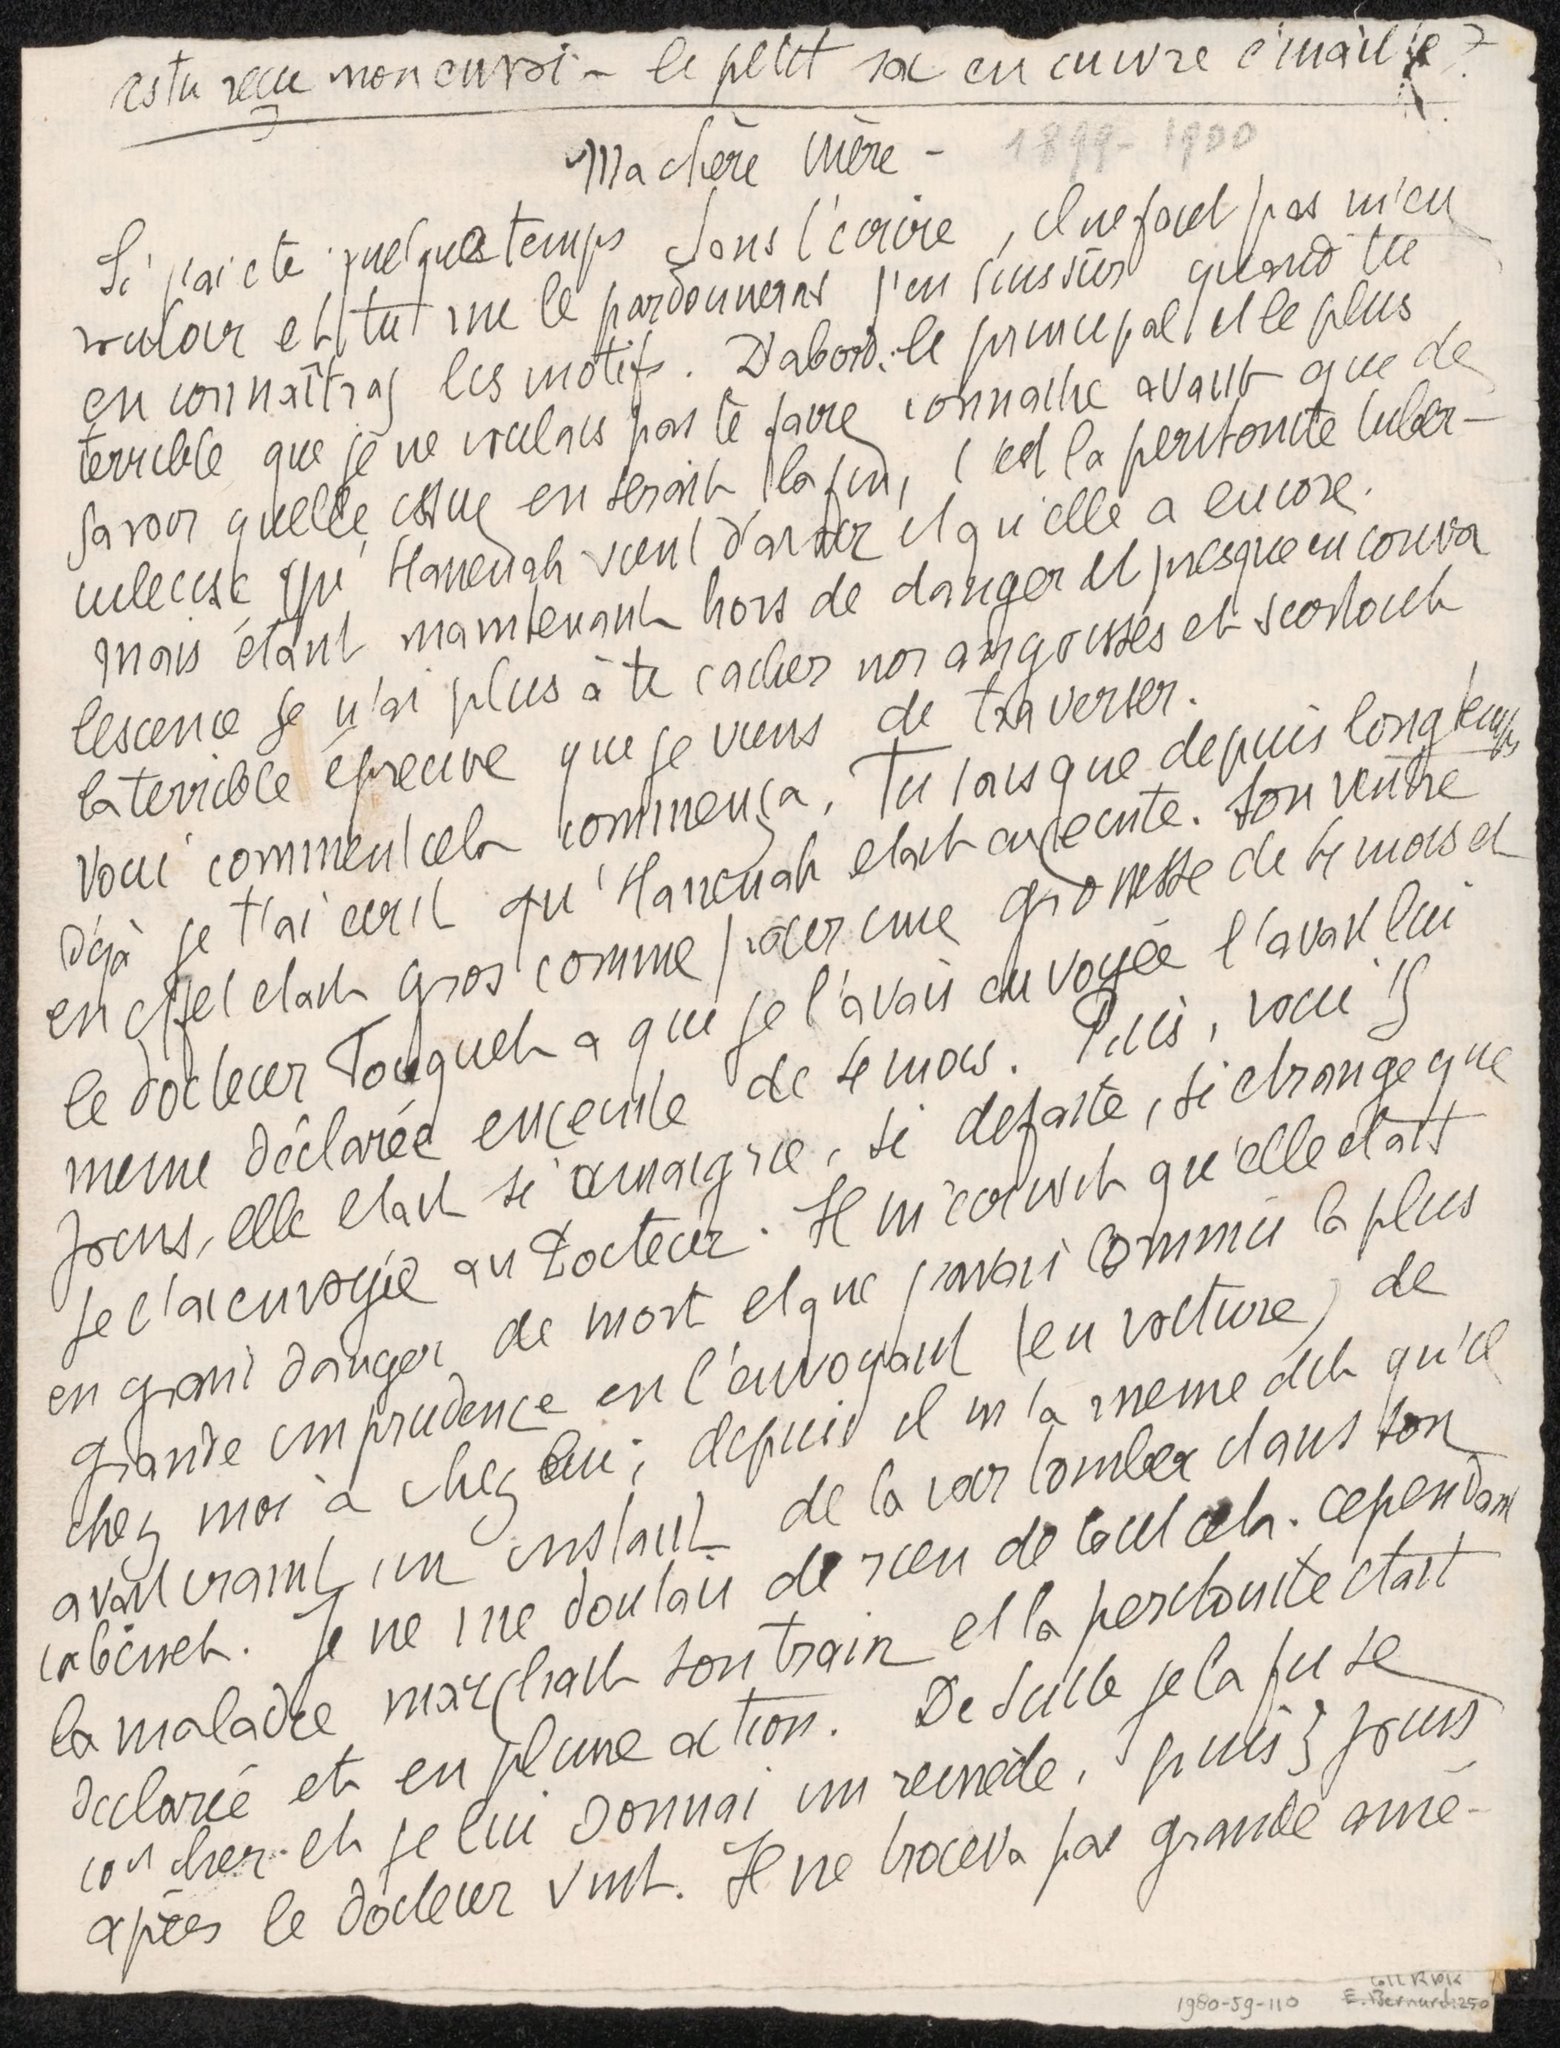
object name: letter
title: Brief aan Héloïse Bernard-Bodin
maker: émile bernard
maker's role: print maker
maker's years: 1868-1941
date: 1878-1941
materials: ink, paper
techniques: pen, writing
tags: héloïse bernard-bodin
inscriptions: watermark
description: Brief gedateerd 1899-1900 in latere hand.